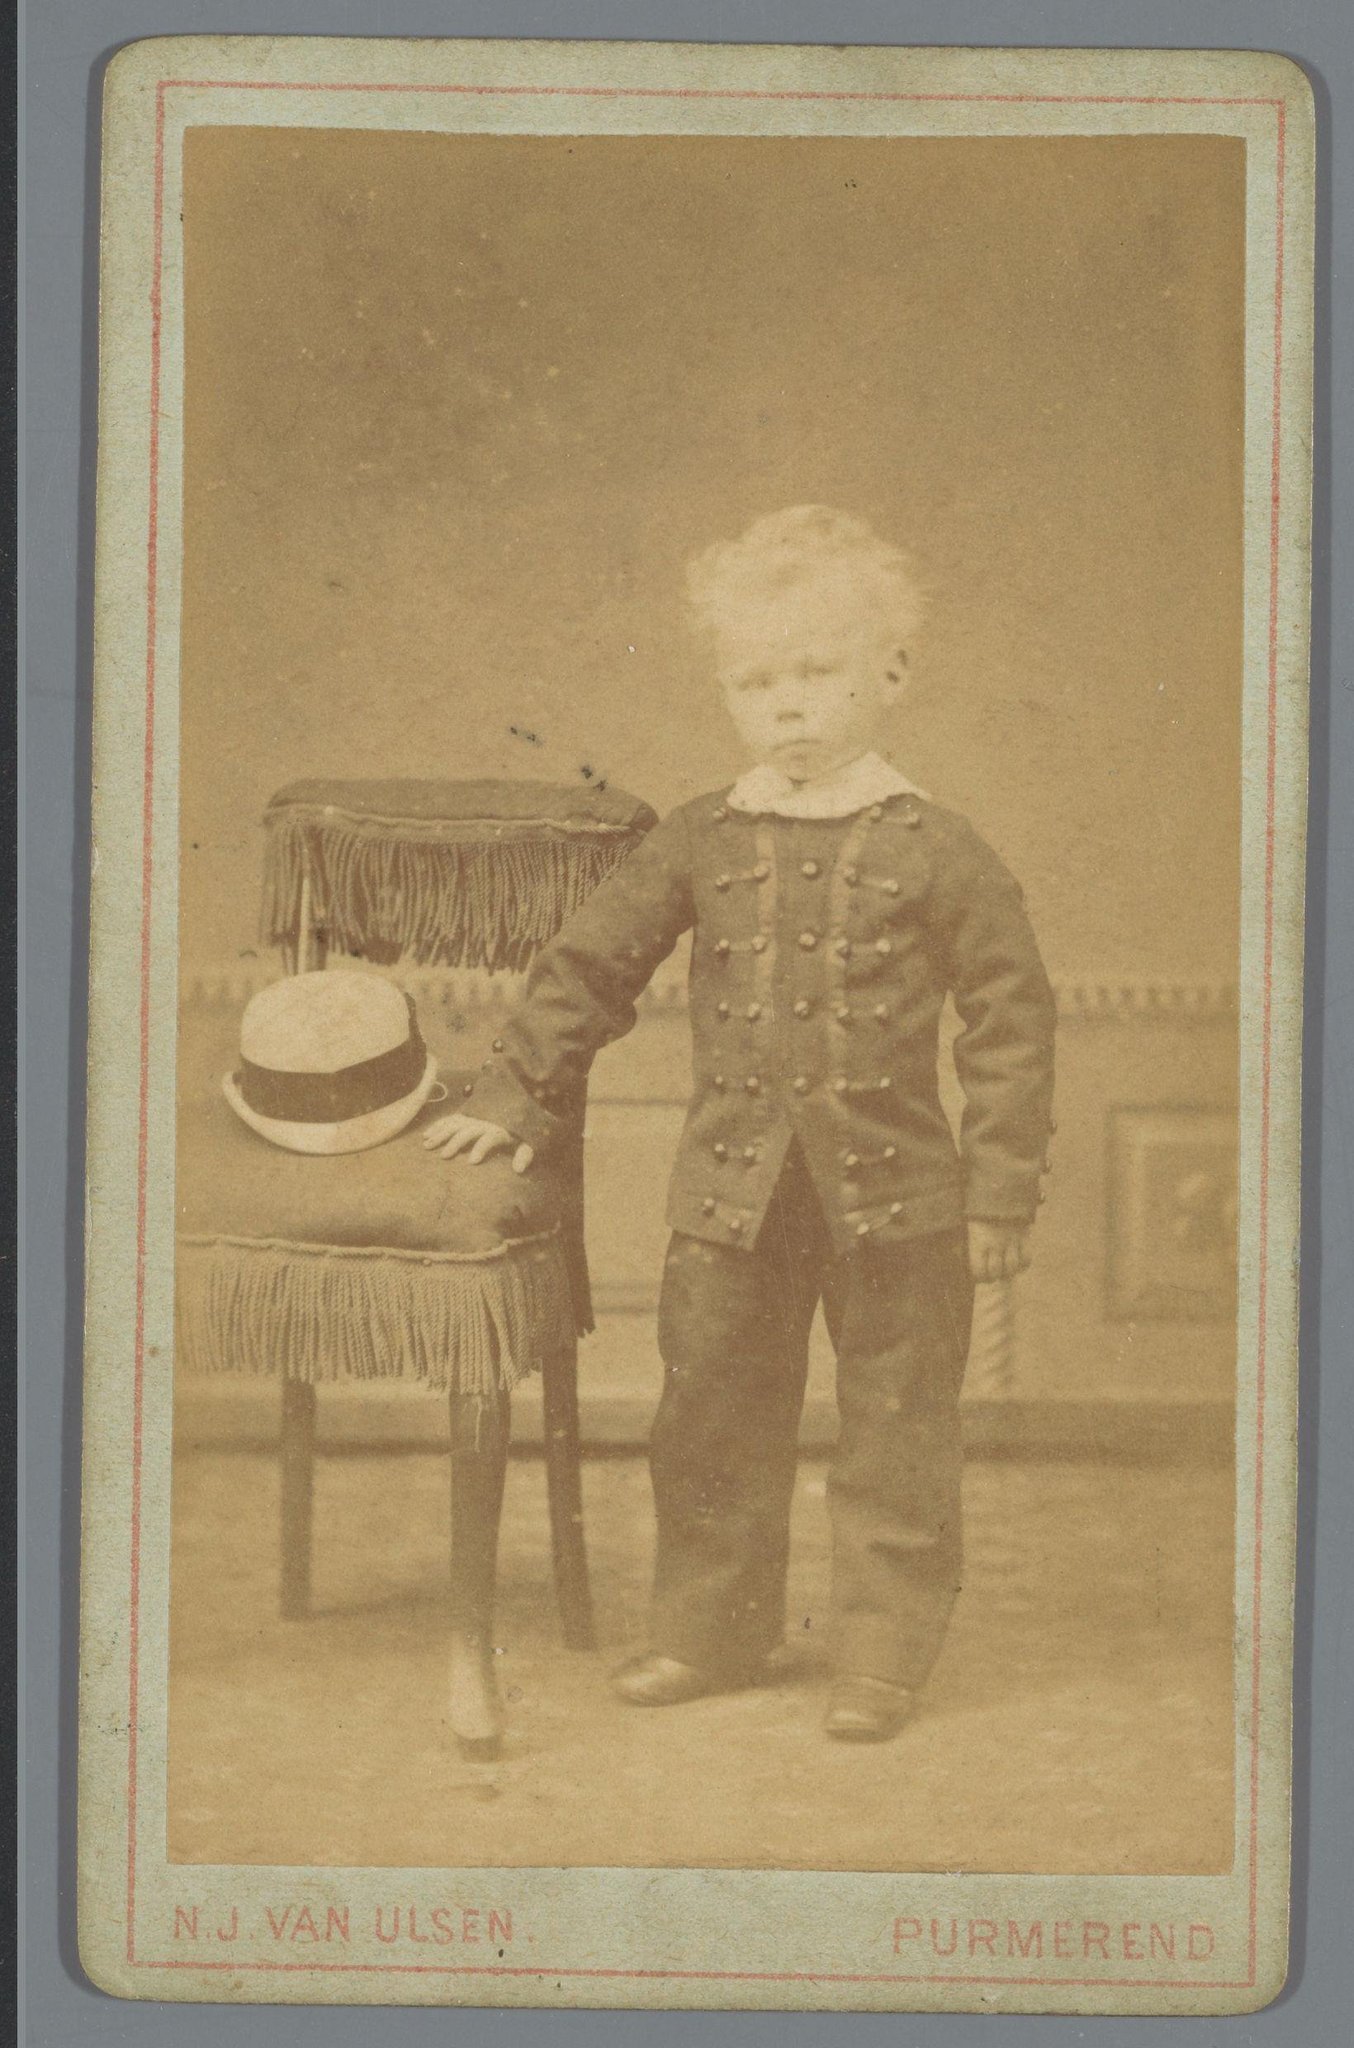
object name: carte de visite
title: Portret van Cornelis Reynders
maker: nicolaas jelles van ulsen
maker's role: fotograaf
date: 1880-1884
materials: cardboard, paper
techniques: albumen print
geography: purmerend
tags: toddler, historical persons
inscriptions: address: ‘KERKSTRAAT/ over de R.C. Kerk 95/ PURMEREND.’, inscription: ‘C. Reynders’